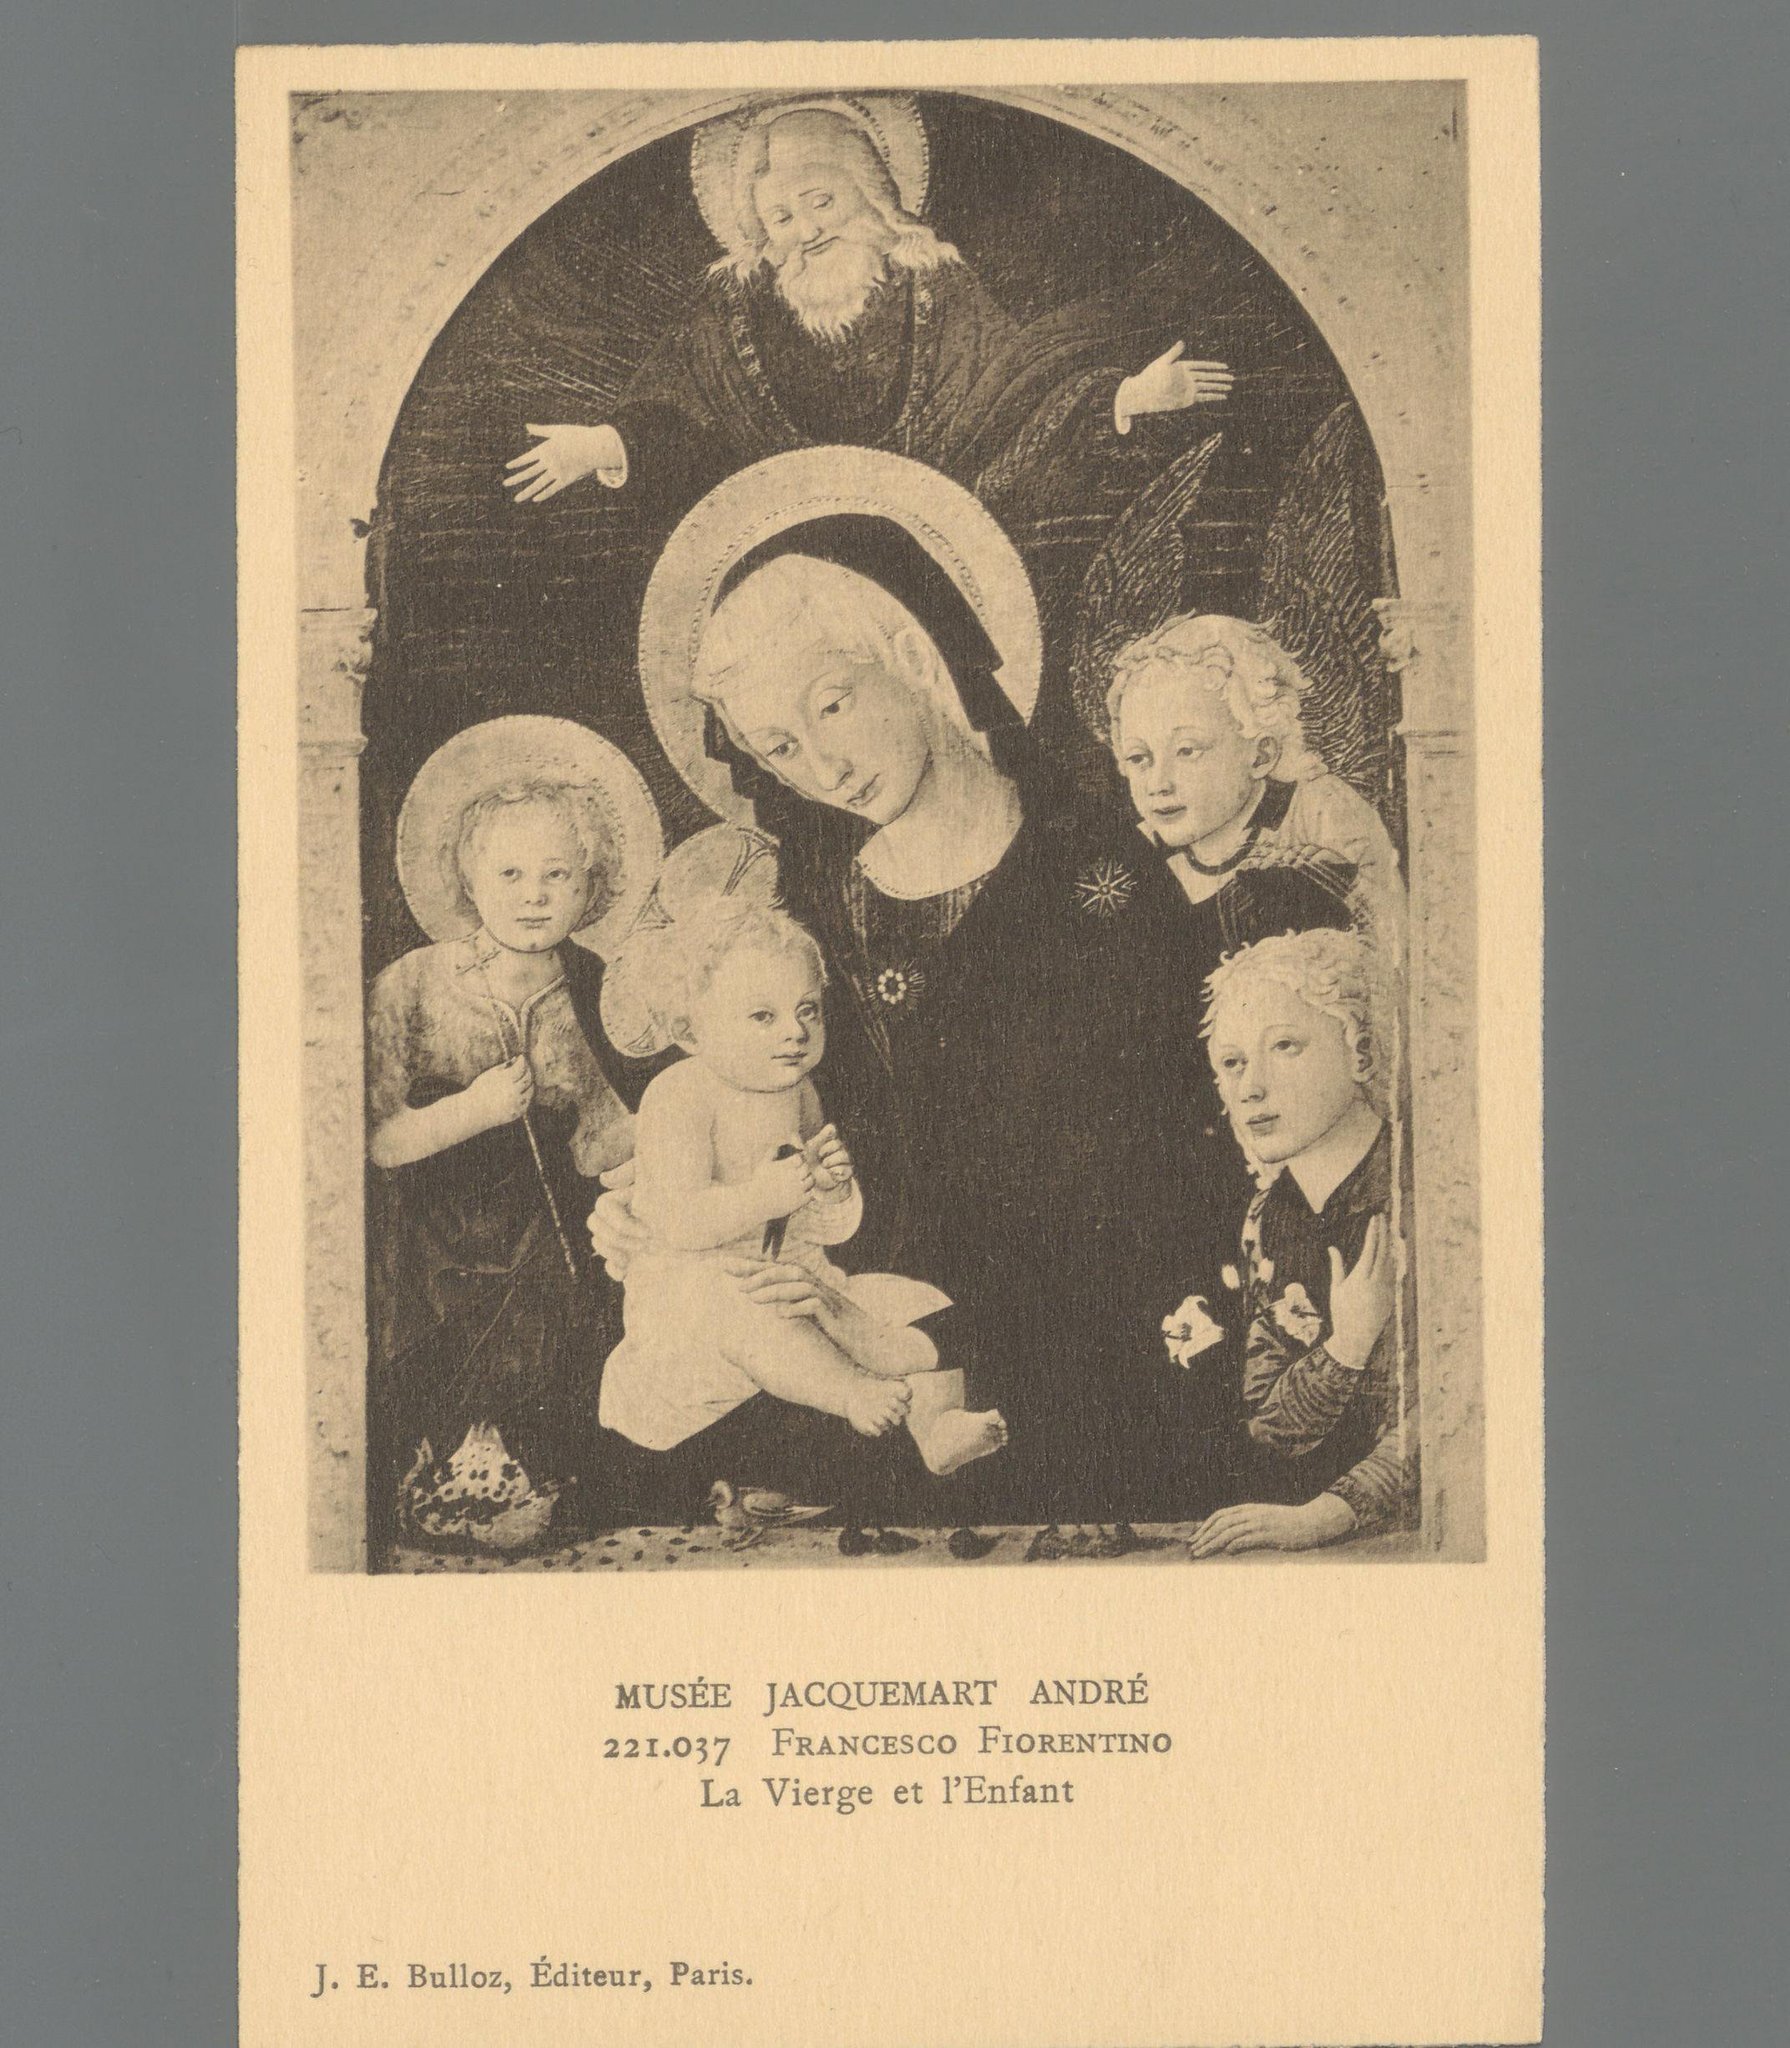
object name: reproduction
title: Musée Jacquemart-André. Francesco Fiorentino. La Vierge et l'Enfant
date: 1903-1930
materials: cardboard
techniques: photograph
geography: paris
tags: permanent exhibition, museum, picture, painting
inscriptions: collector's mark: ‘AFE v S’